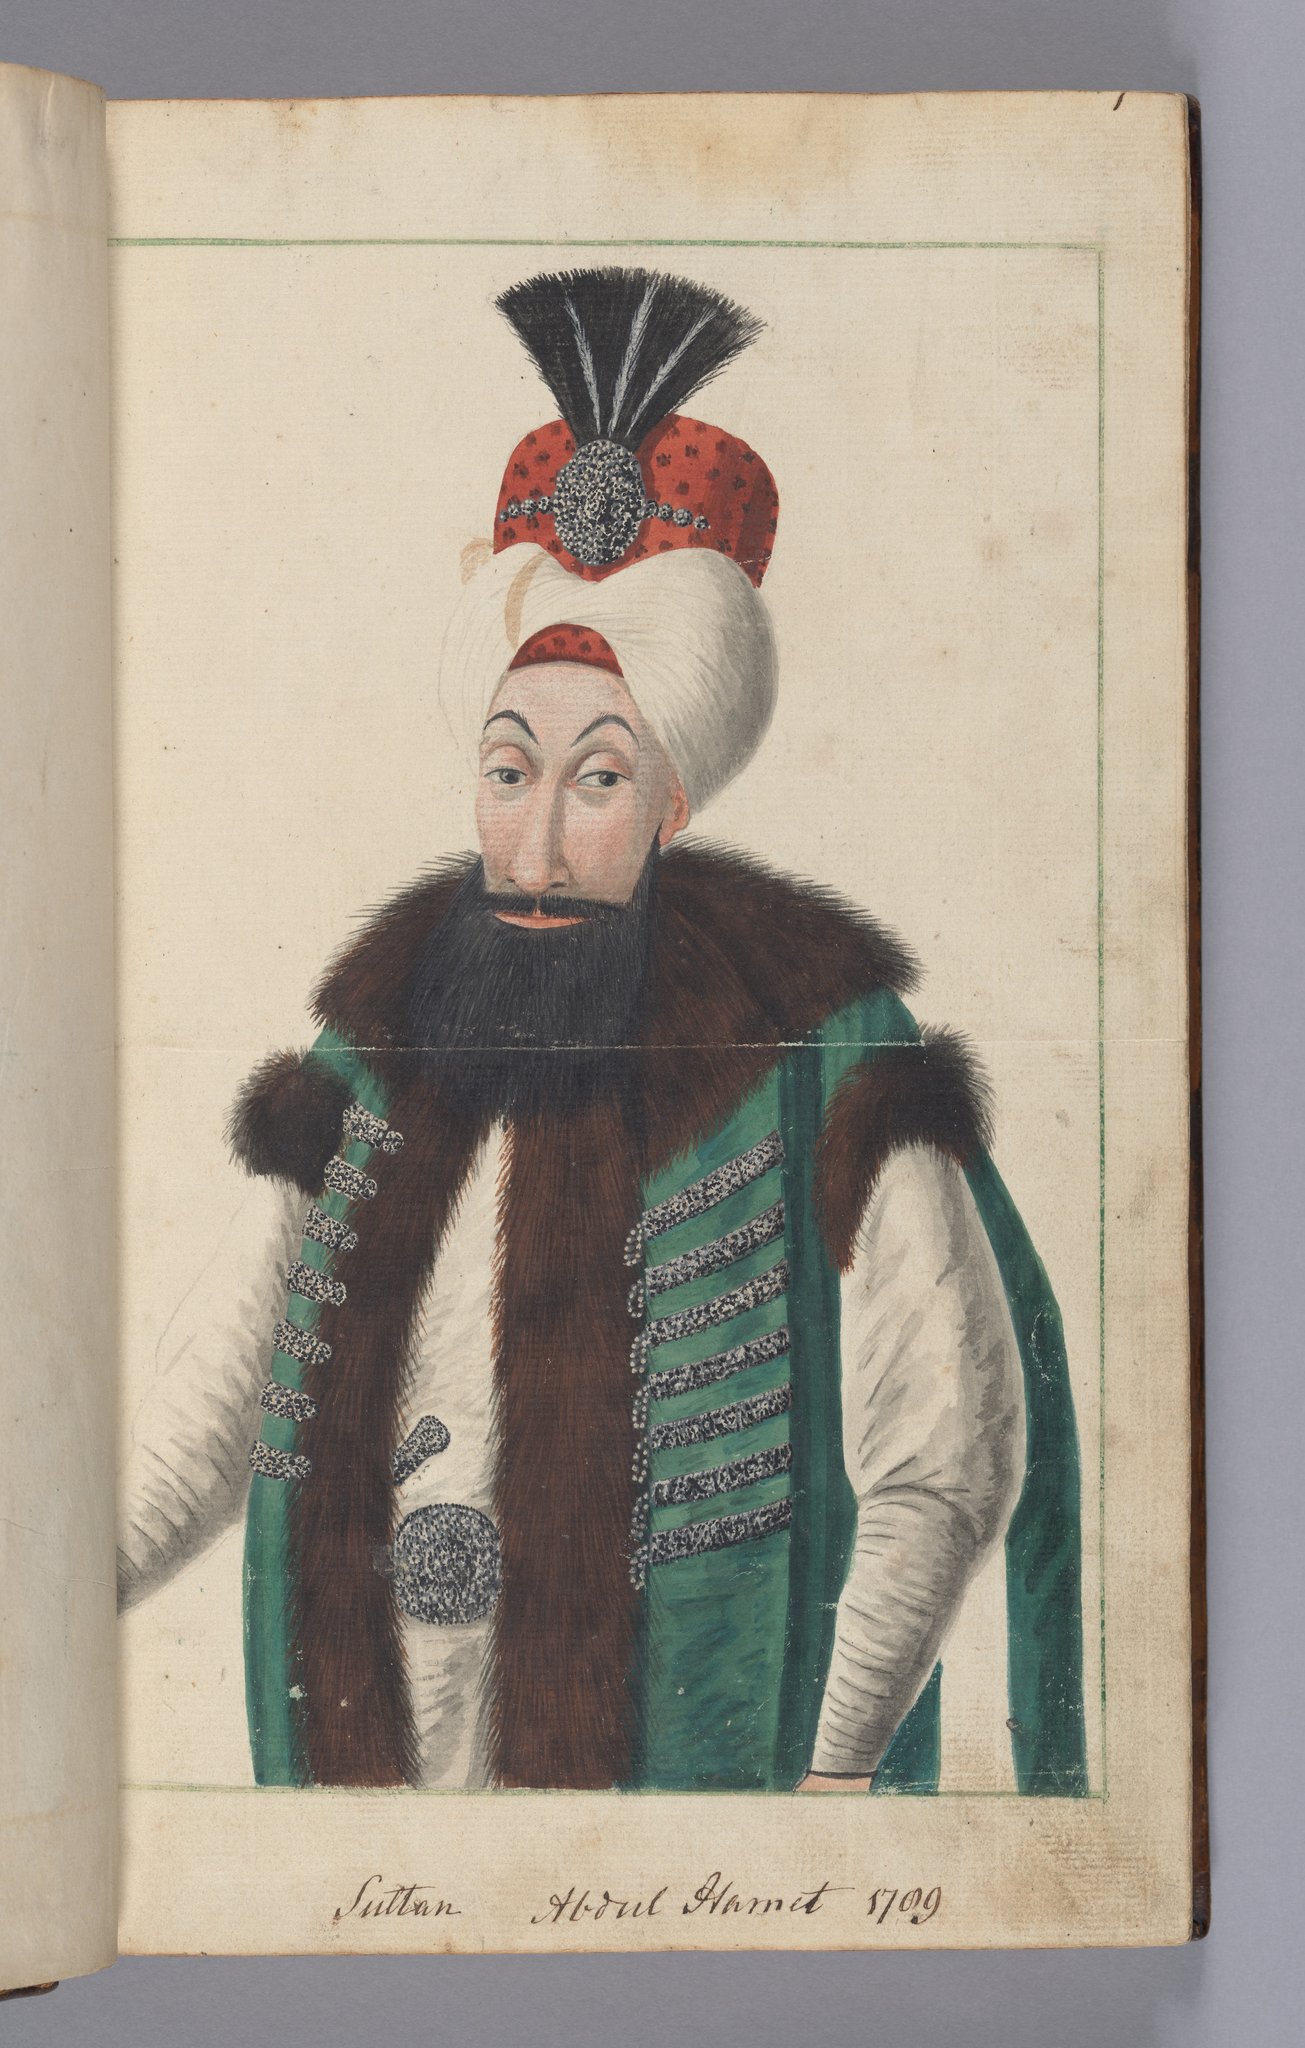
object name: illustrated manuscript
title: Illustrated Manuscript: ‘Costumi Turchi e Grechi fatti in Constantinopoli 1790’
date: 1790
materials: gold, ink, leather, paper, watercolor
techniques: bookbinding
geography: turkey